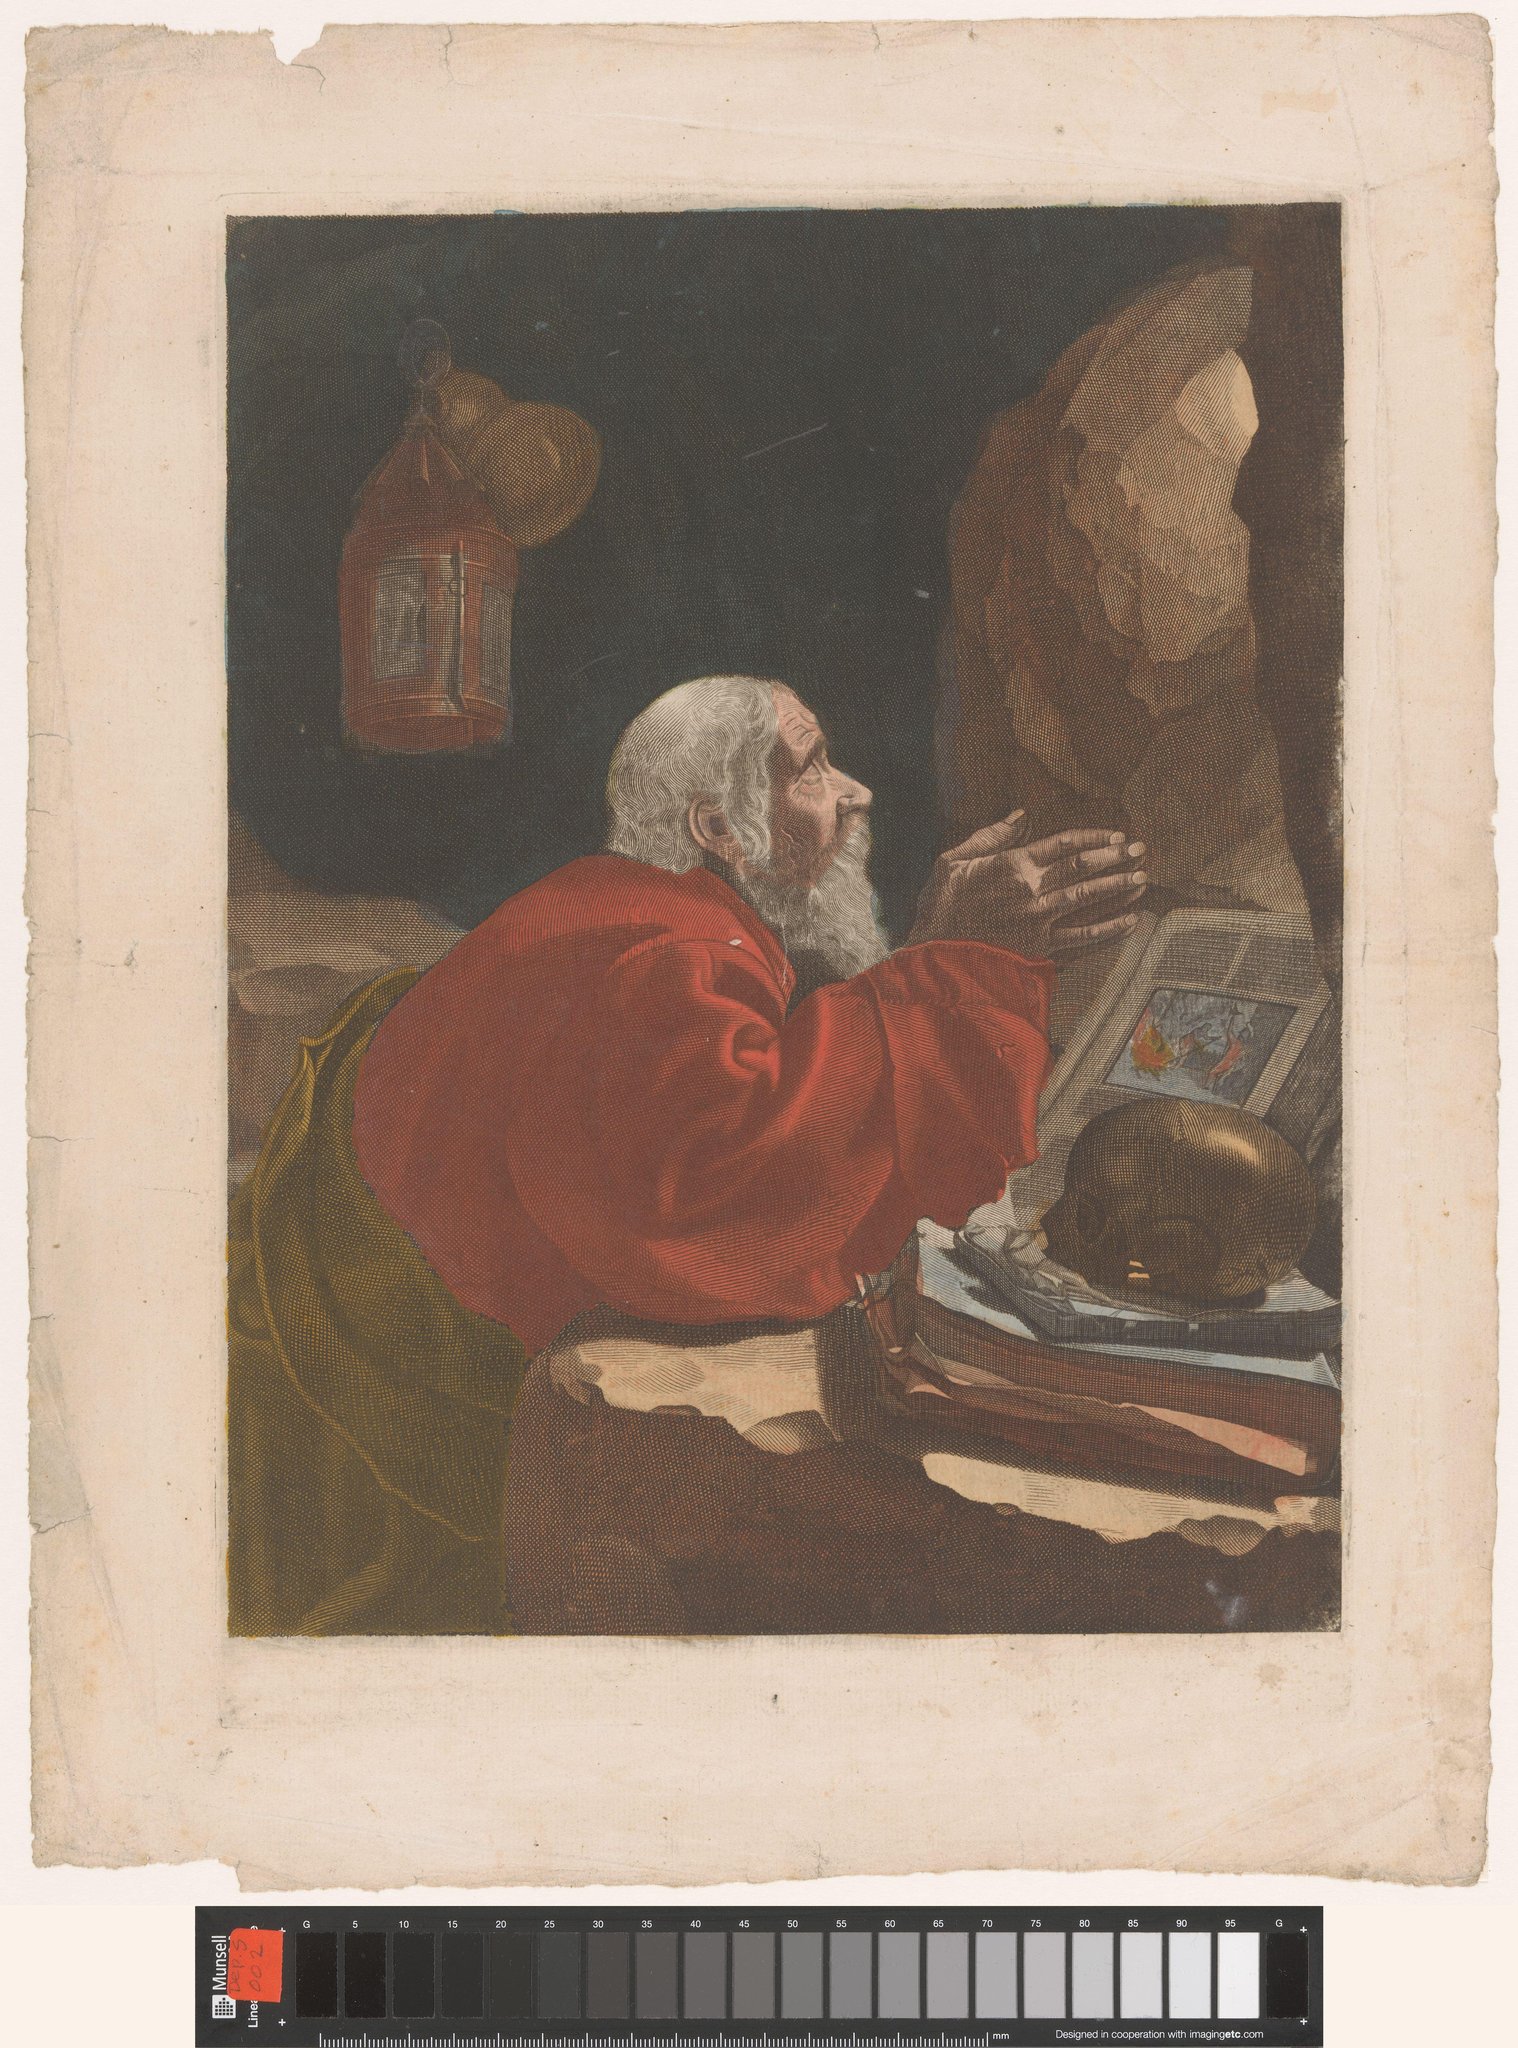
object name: print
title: Boetvaardige H. Hieronymus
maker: Anonymous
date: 1650-1750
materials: paper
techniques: engraving, hand coloring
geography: france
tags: st. jerome as penitent in his study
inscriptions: collector's mark: Lugt 2228